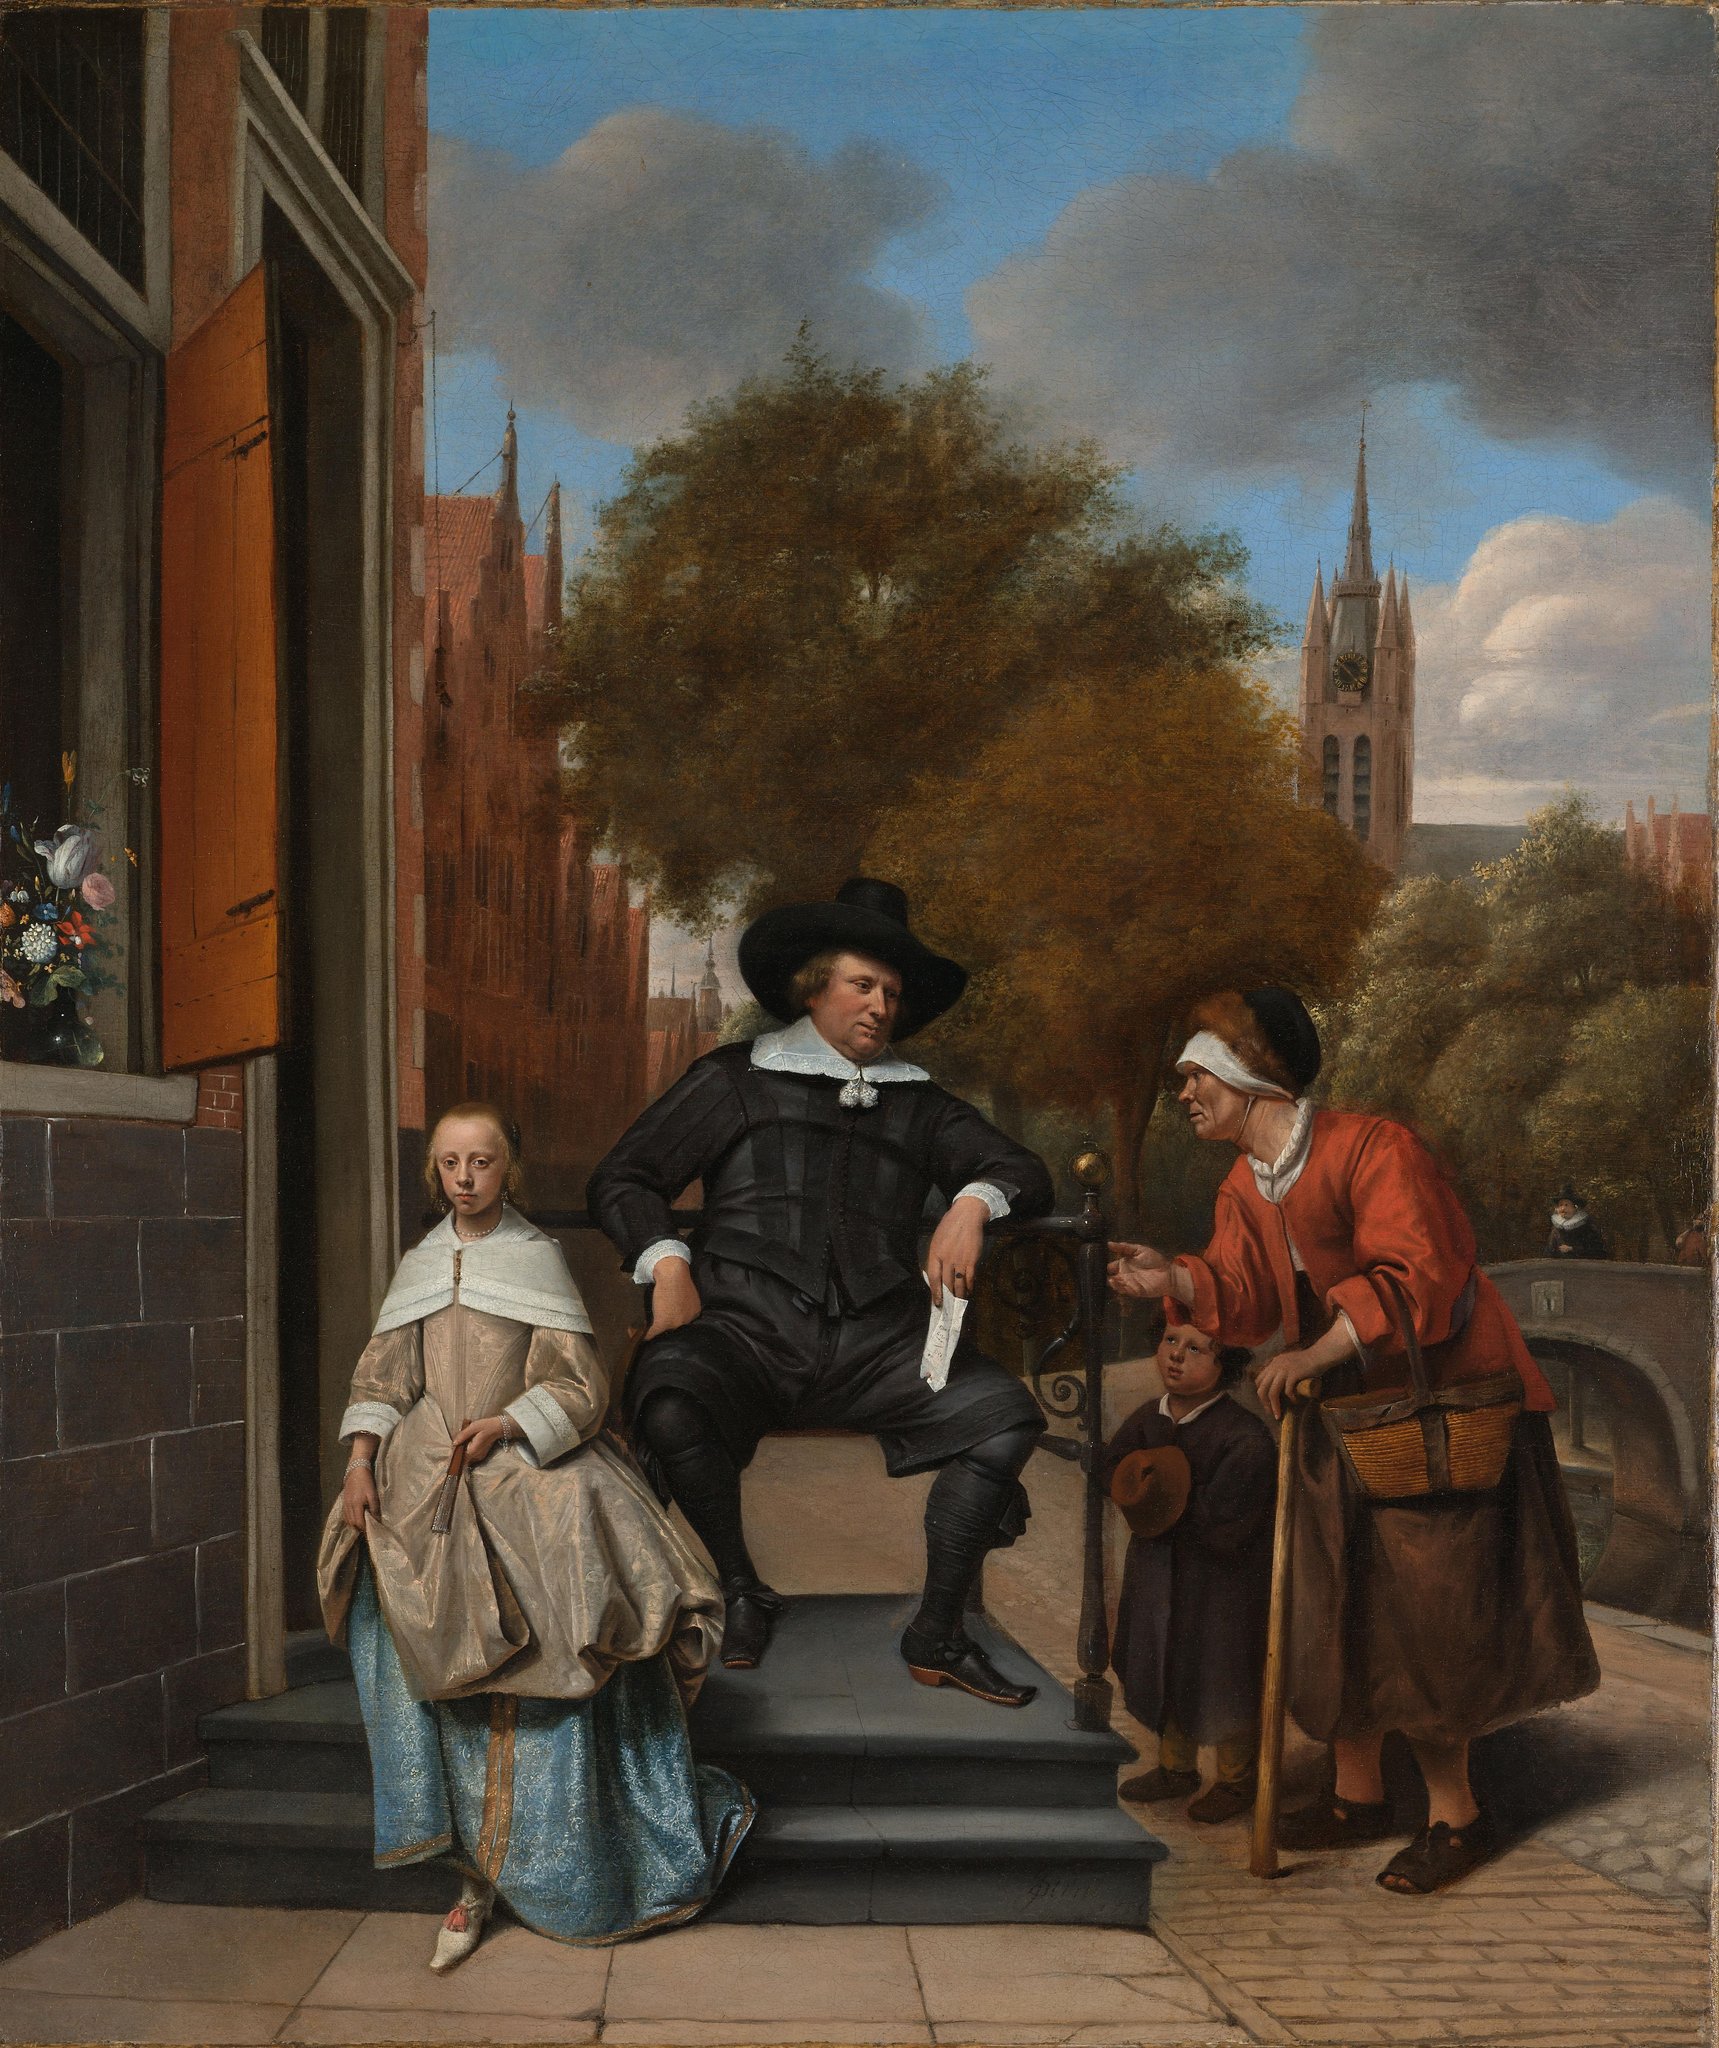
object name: painting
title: Adolf and Catharina Croeser, Known as ‘The Burgomaster of Delft and his Daughter’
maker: jan havicksz. steen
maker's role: painter, print maker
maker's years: 1625-1679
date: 1655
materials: canvas, oil, paint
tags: father and daughter(s) (family group), cut flowers; nosegay, bunch of flowers, village street, contrast between rich and poor, beggar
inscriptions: signature and date: ‘JSteen // 1655’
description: Legs wide apart and his right arm akimbo, Croeser sits on the stoop of his house on the Oude Delft canal in Delft. His thirteen-year-old daughter Catharina looks straight out at us. Jan Steen included a narrative element in this portrait: a poor woman and child beg for alms from the wealthy grain merchant. In 1657, just two years after this portrait was made, Croeser stood surety for Steen, who was seriously in debt.